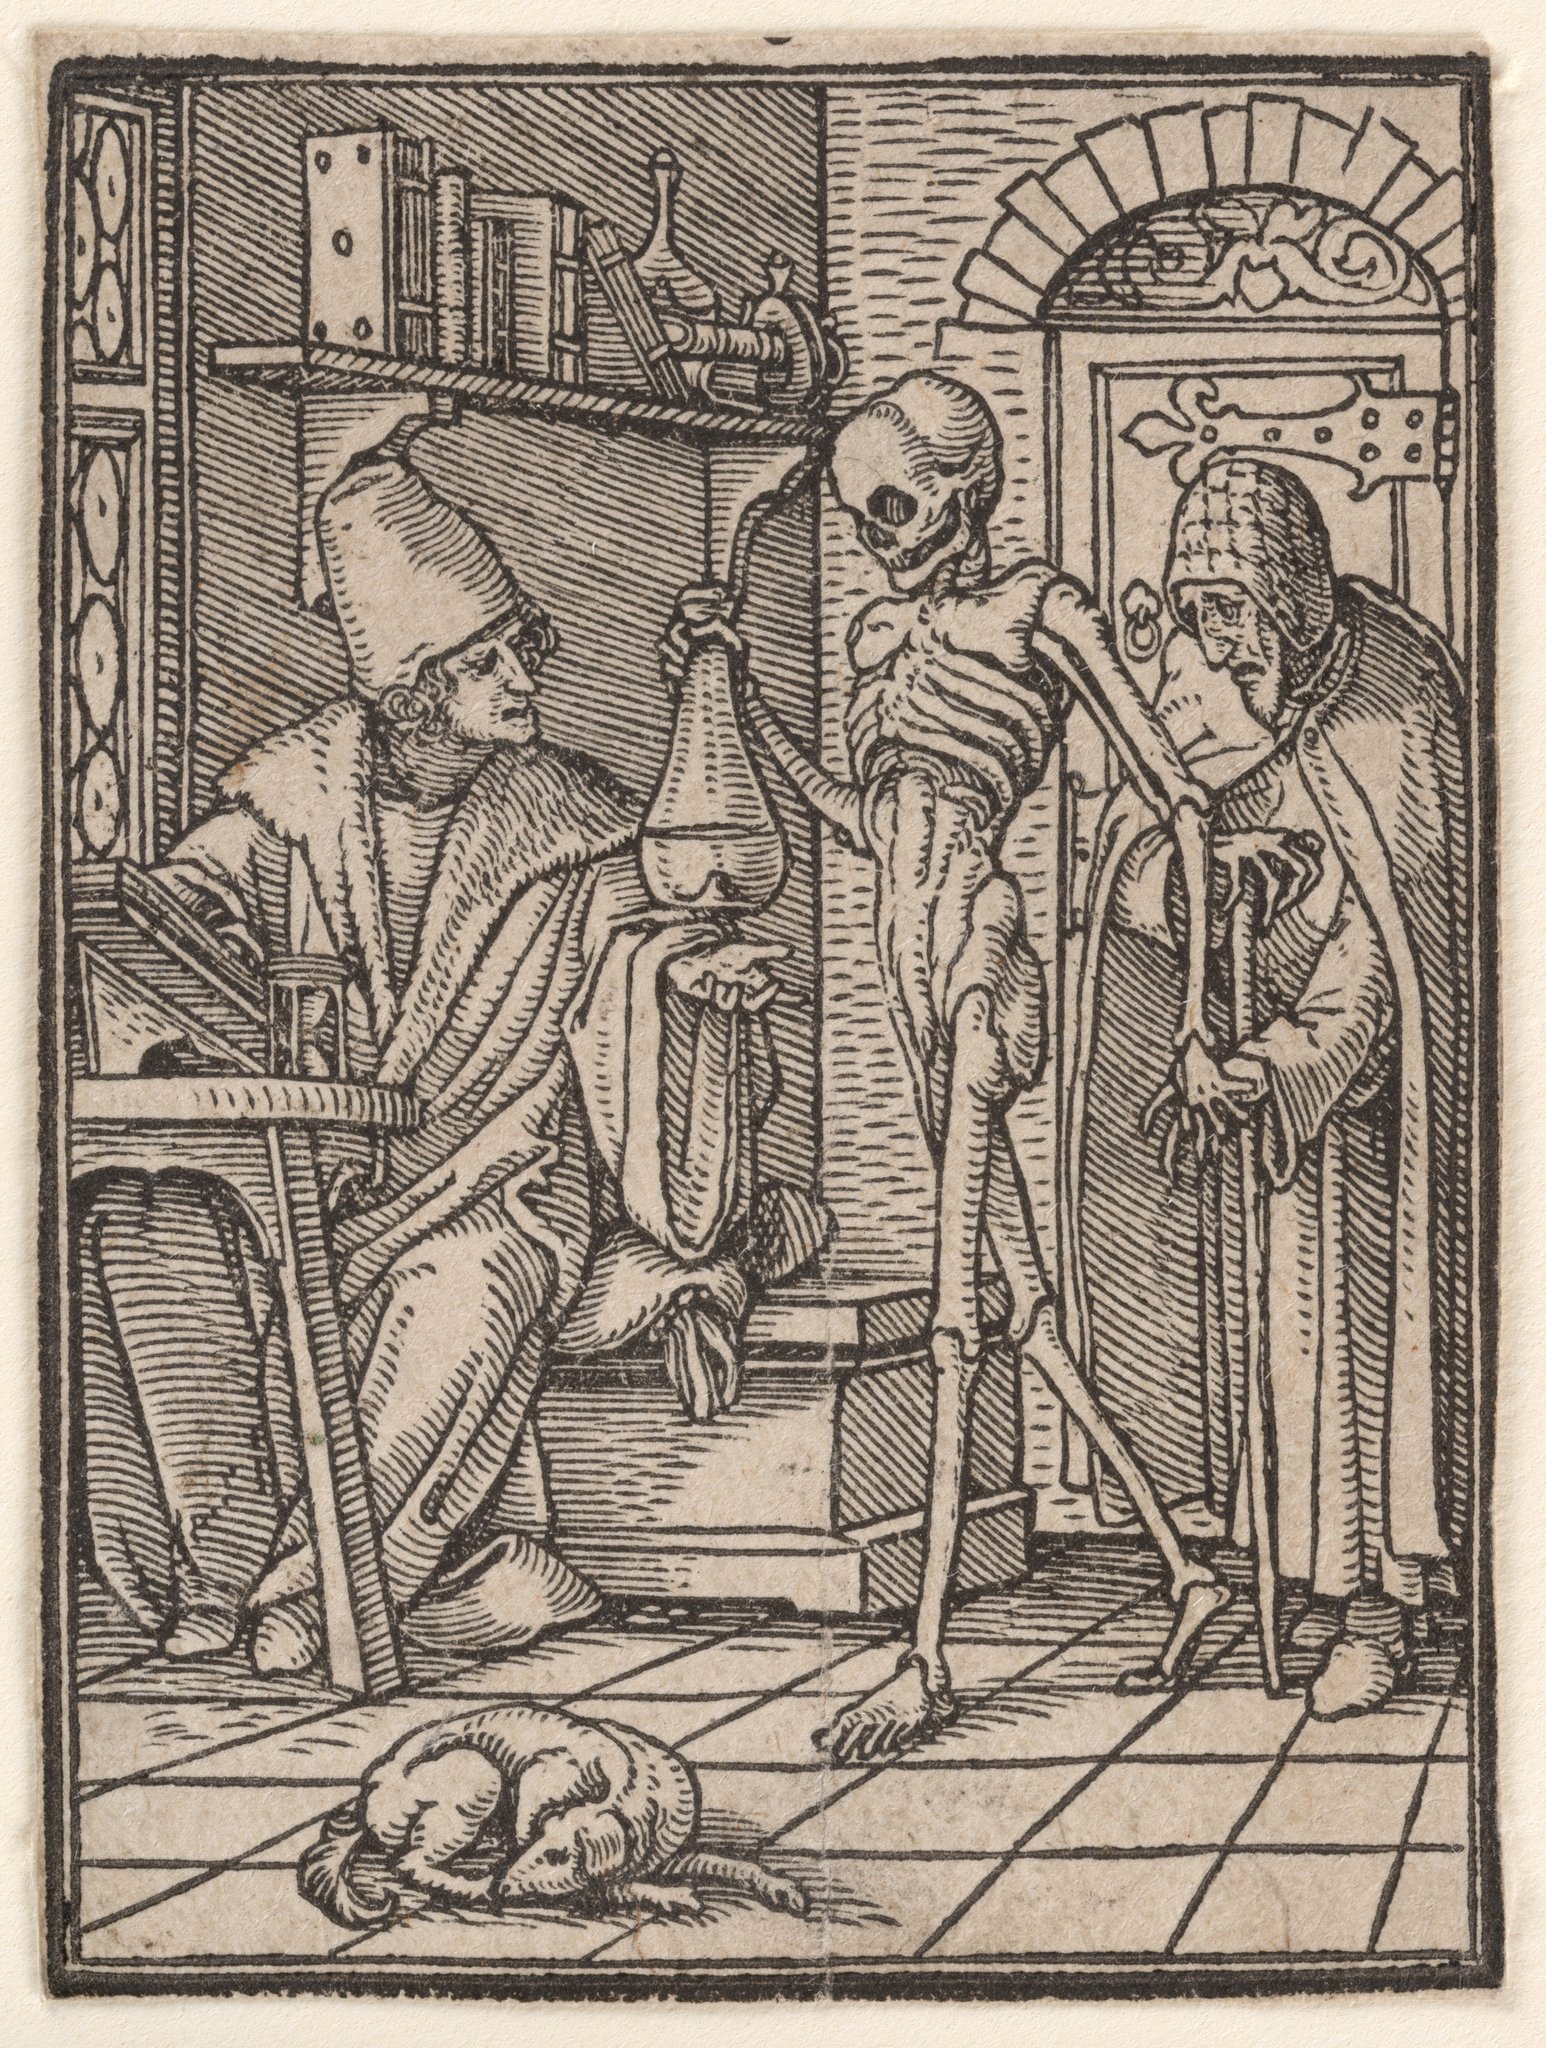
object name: print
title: The Doctor (or Physician), from "The Dance of Death"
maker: hans holbein the younger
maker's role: artist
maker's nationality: german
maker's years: 1497-1543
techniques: woodcut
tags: skeletons,men,dogs,death